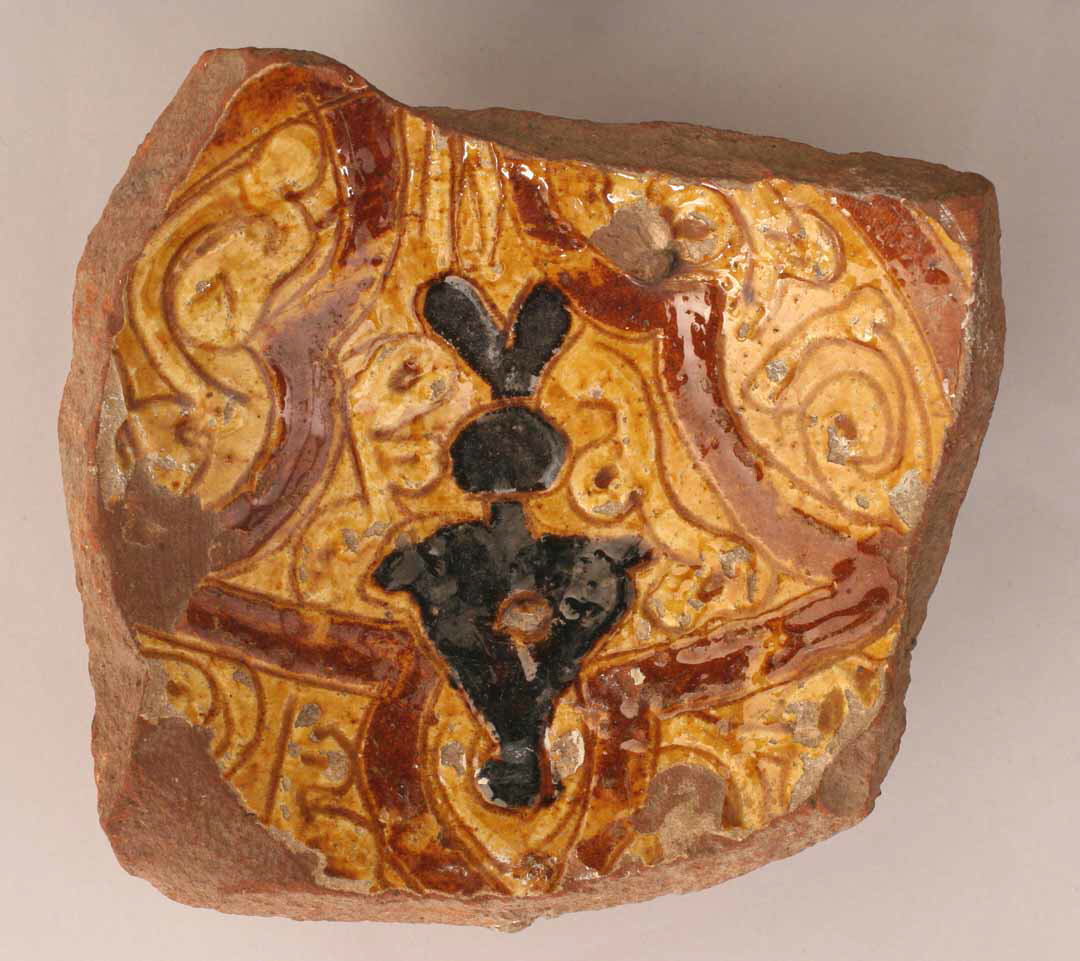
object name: fragment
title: Ceramic Fragment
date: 1301-1400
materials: earthenware, glaze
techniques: incising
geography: egypt